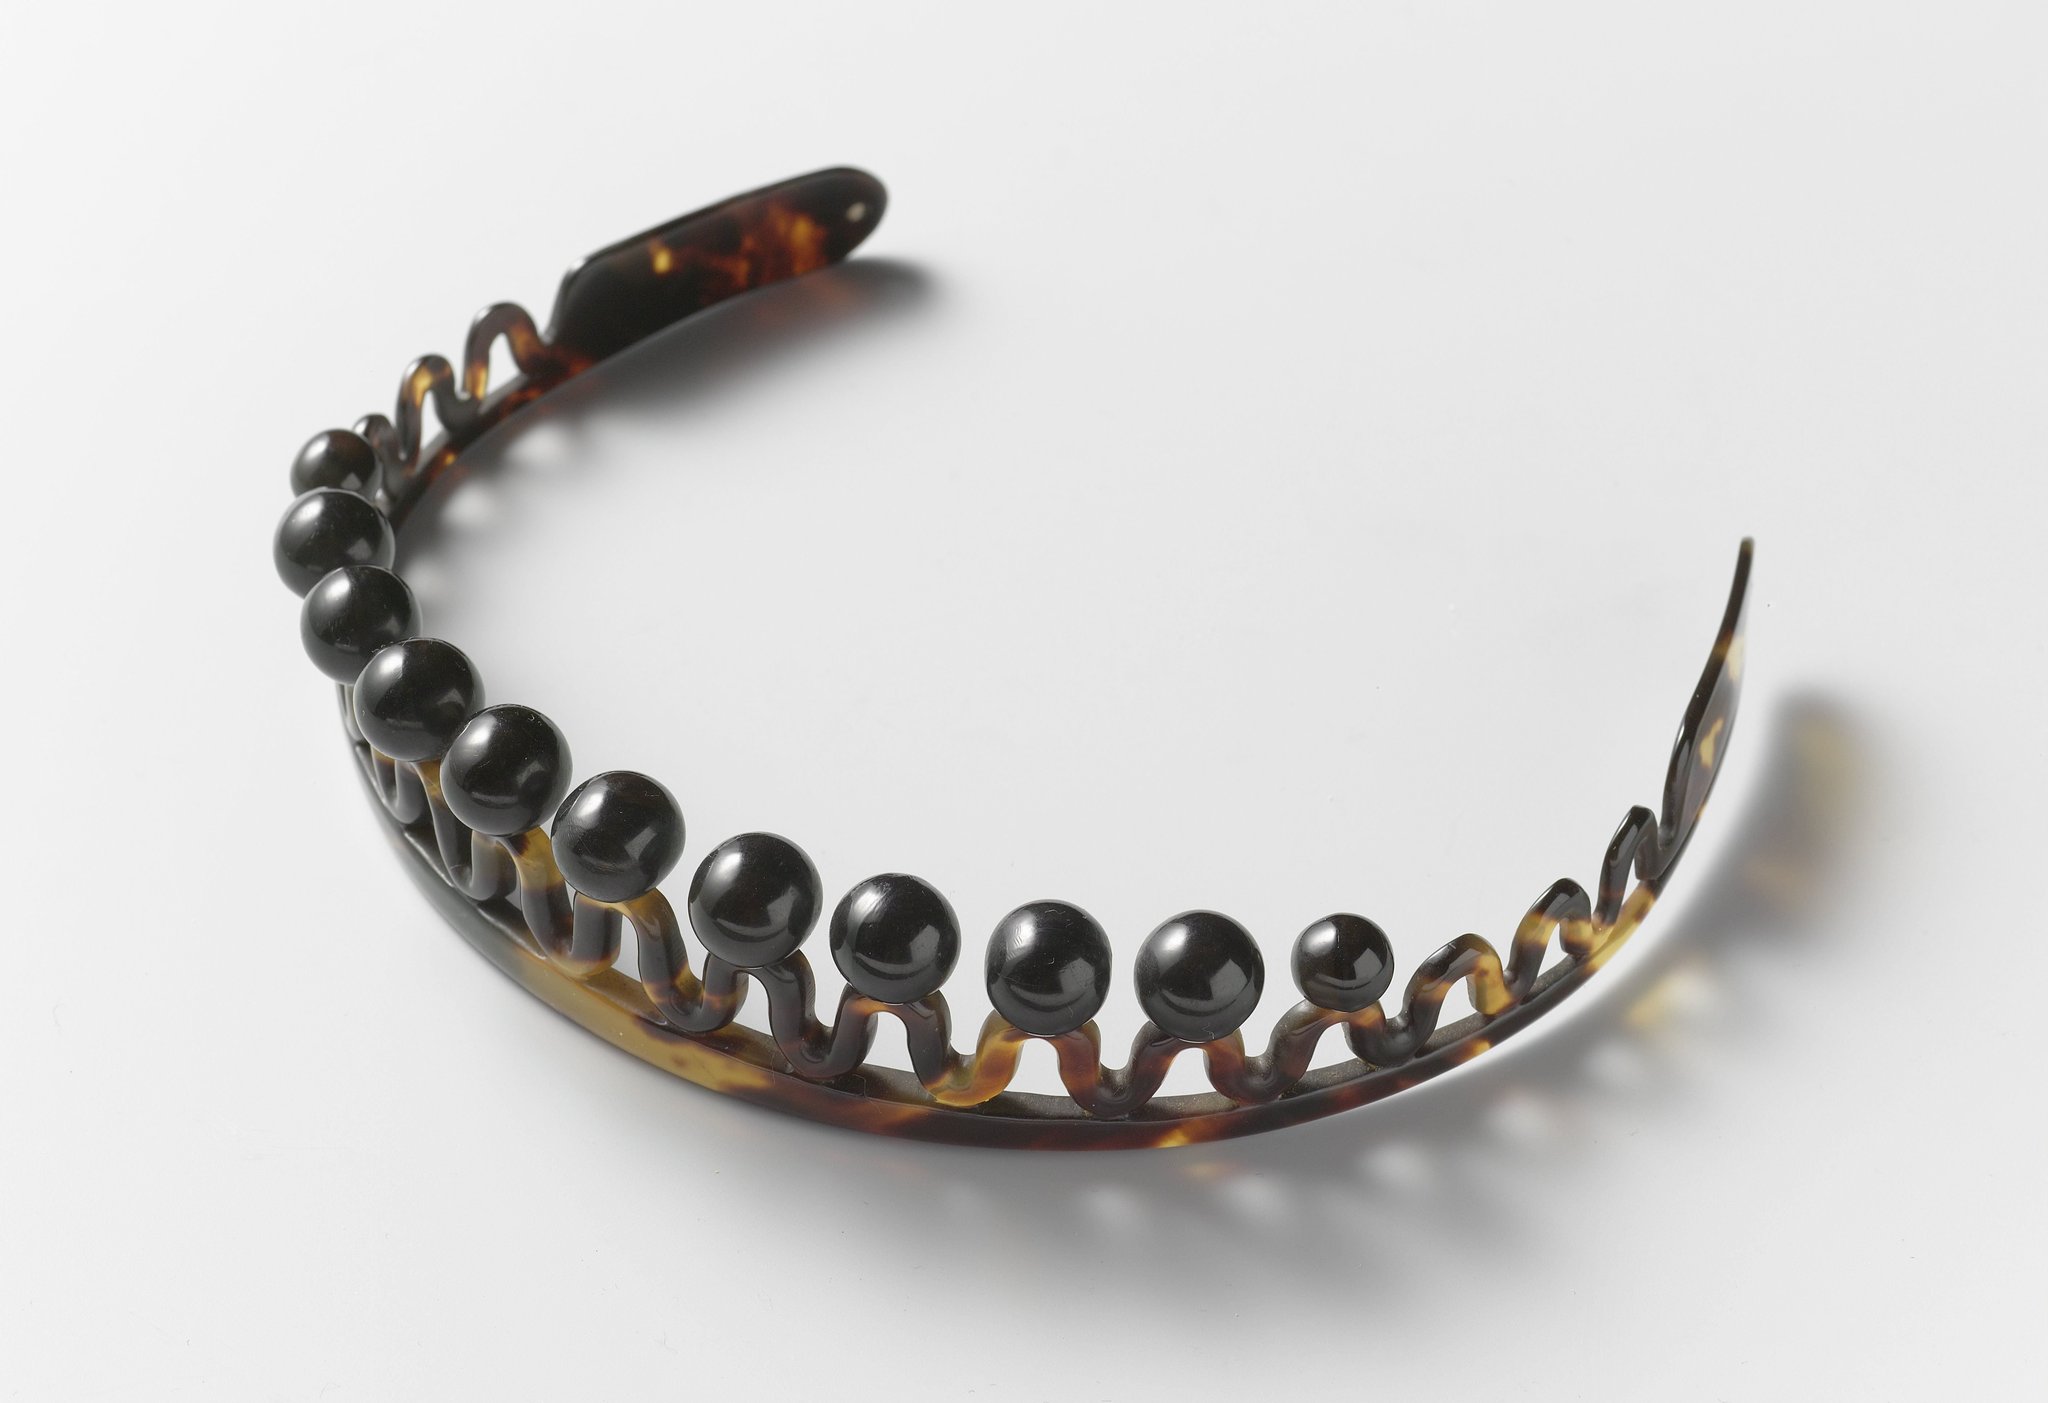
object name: diadem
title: Diadeem van kunststof met schildpadmotief, driekwart cirkelvormig met bollen op de golvende rand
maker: Anonymous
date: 1890-1914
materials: plastic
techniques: pressing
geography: netherlands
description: Diadeem van schildpad, met een golvende open rand met daarop zwarte bollen. Met de ontdekkingen tijdens de opgravingen in de tweede helft van de 18de eeuw groeide de belangstelling voor de oudheid. In Frankrijk kwamen na de Revolutie Griekse en Romeinse kapsels in de mode. Ook het in de oudheid vaak gedragen diadeem was helemaal terug en werd op het opgestoken haar geplaatst.